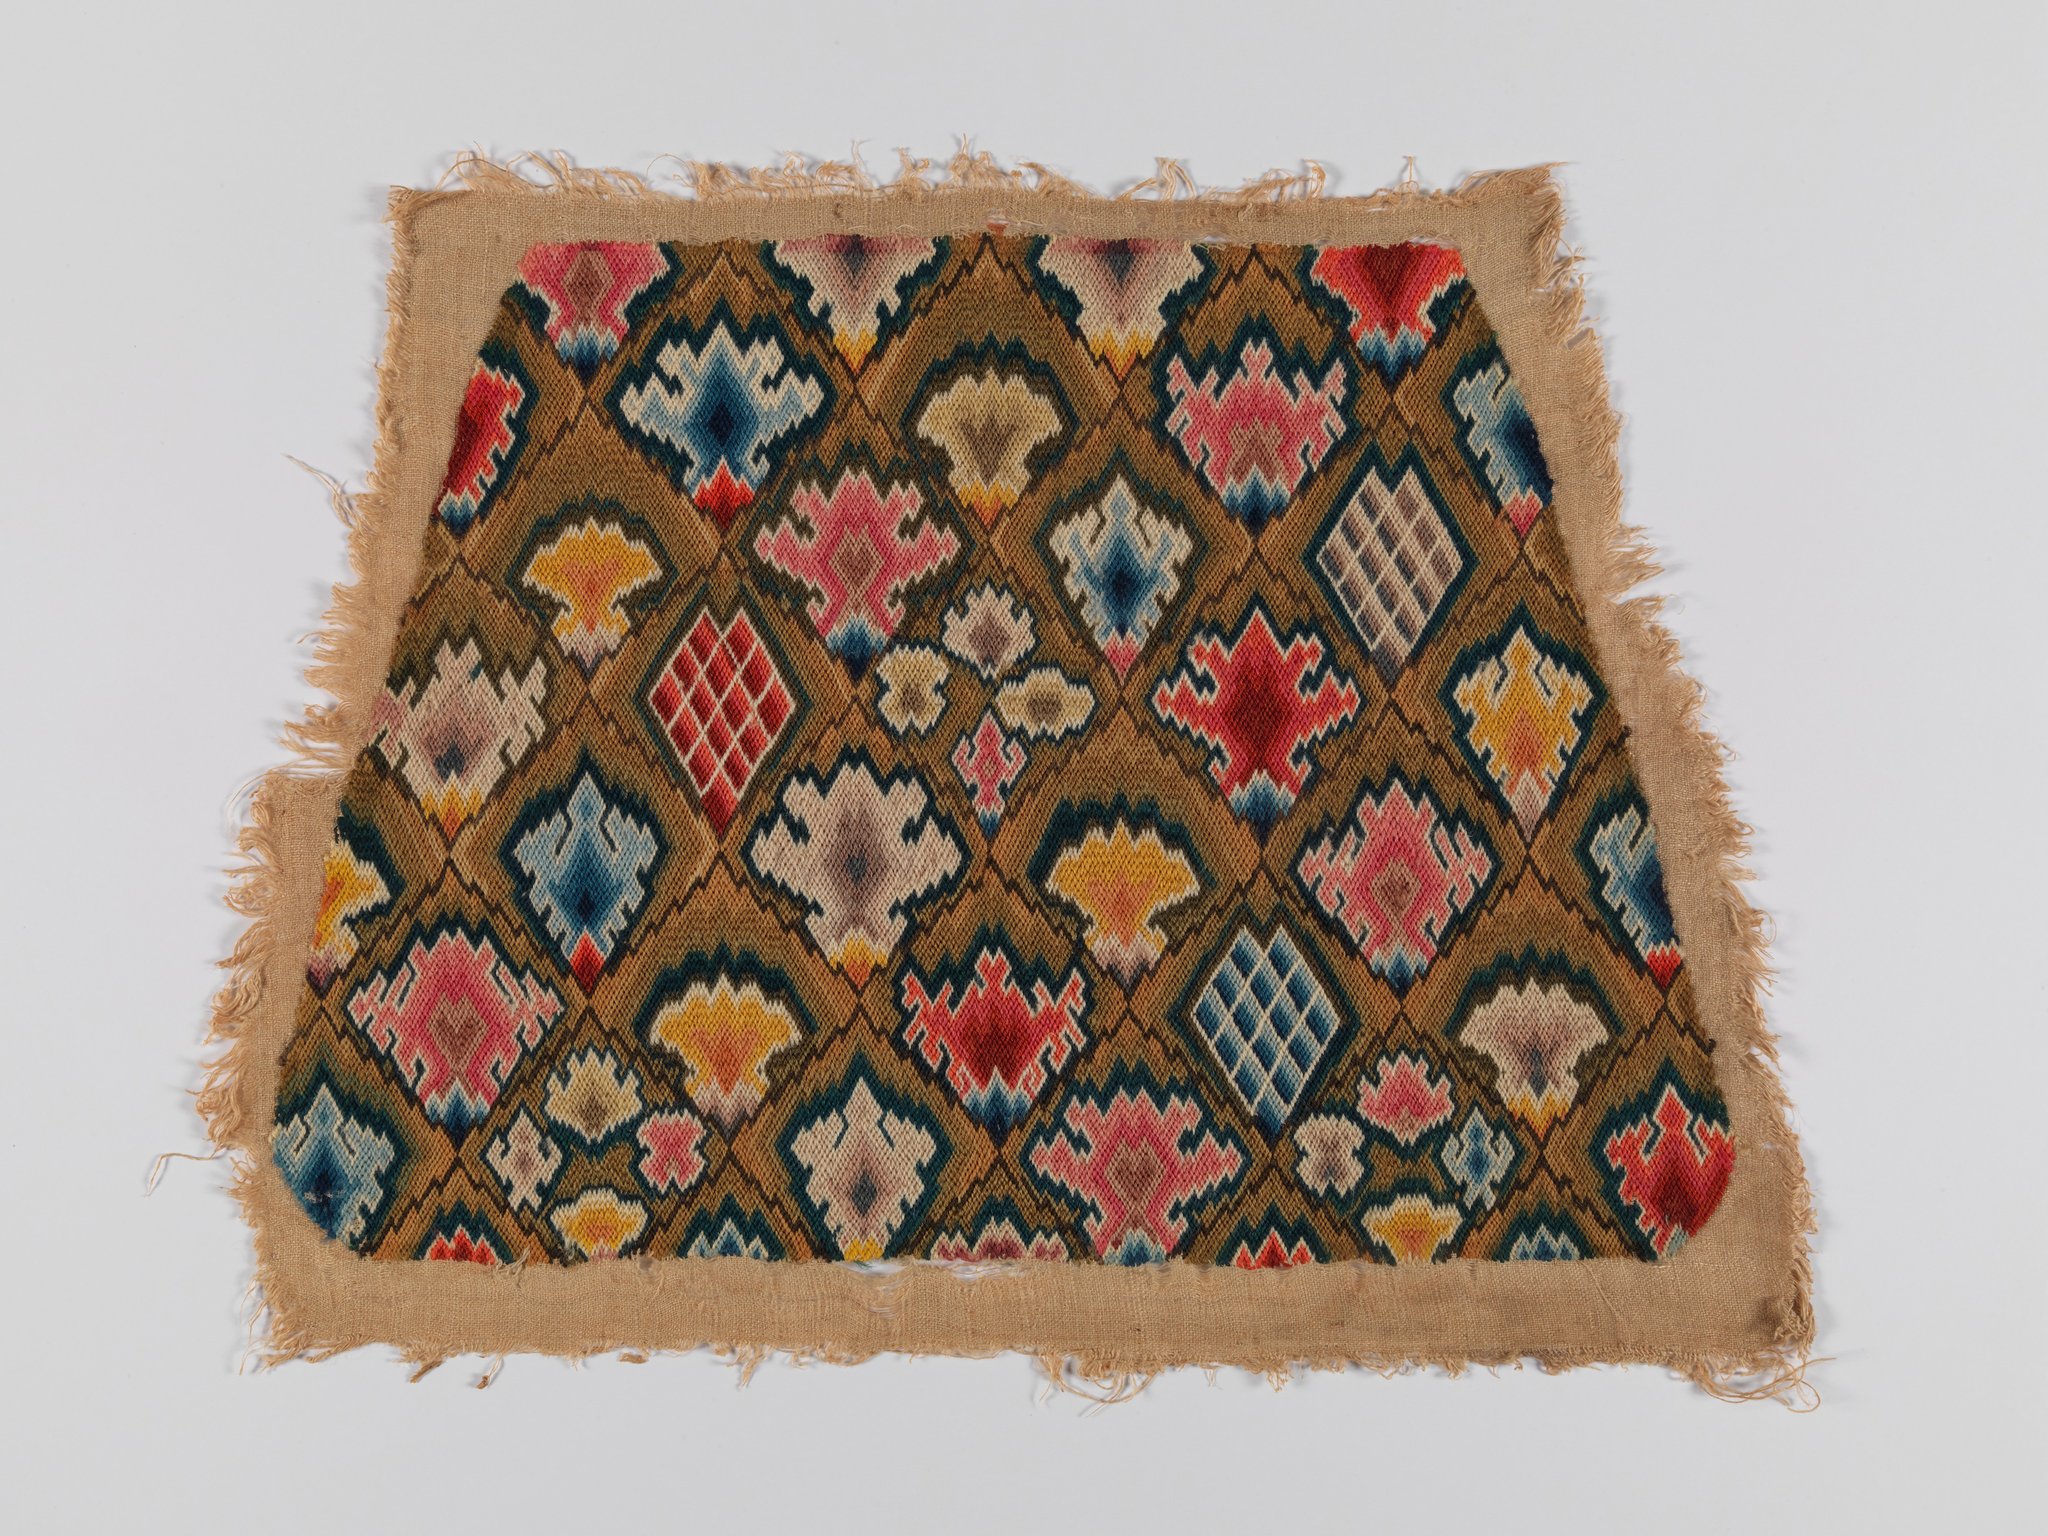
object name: seat cover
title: Chair seat cover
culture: american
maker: anna poor parsons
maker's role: maker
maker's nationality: american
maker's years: 1738-1783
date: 1770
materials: linen, wool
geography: united states